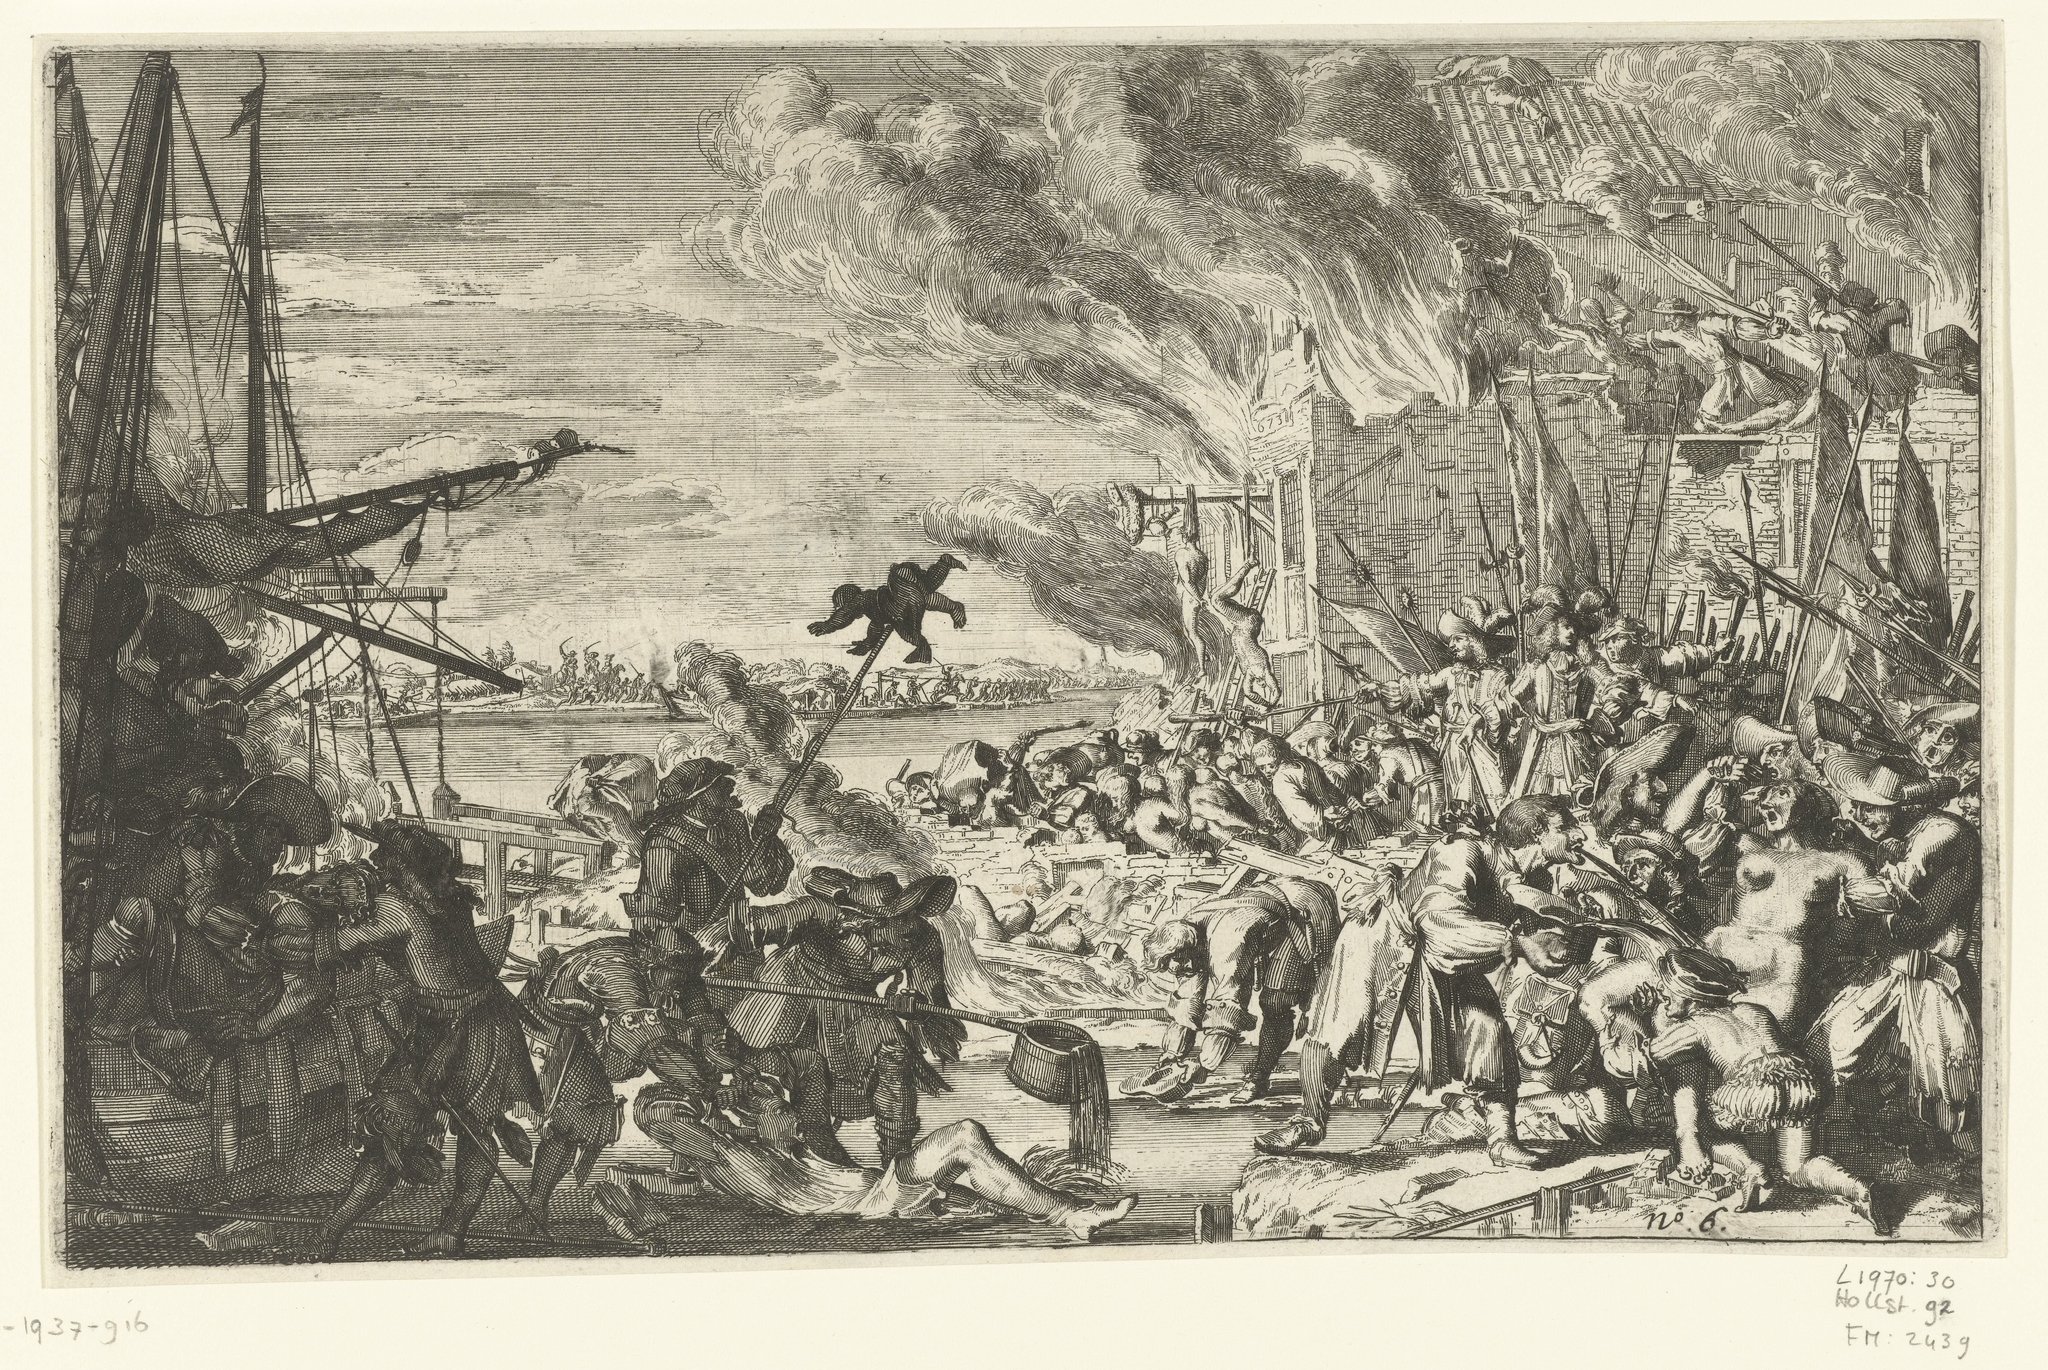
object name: print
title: Wreedheden in een dorp aan het water, 1672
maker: Anonymous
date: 1673-1675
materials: paper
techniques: engraving, etching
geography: netherlands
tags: massacre ~ war, bodegraven, rampjaar (disaster year)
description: Prent ook gebruikt in: Bosch, Lambert van den. Toneel des oorlogs, opgerecht in de Vereenigde Nederlanden; door de wapenen van de koningen van Vrankrijk en Engeland, Keulsche en Munstersche (…). 4 delen. Amsterdam: Jacob van Meurs en Johannes van Someren, 1675, dl. 3, p. 128. In tegenstelling tot de andere prenten in deze reeks is deze voorstelling niet opgenomen in: Valckenier, Peter en Andreas Muller. Das verwirrte Europa (…). 3 delen. Amsterdam: Hendrik en Dirk Boom, Joannes van Someren en Jacob van Meurs, 1677-1683, dl. 1 (1677). Deze prent is gekopieerd naar een prent van Romeyn de Hooghe (RP-P-OB-77.198). Die prent is gebruikt in: Wicquefort, Abraham van. Avis fidelle aux veritables hollandois. Touchant ce qui s’est passé dans les villages de Bodegrave & Swammerdam, & les cruautés inoüies, que les françois y ont exercées (…). S.l. [Den Haag]: s.n.[Daniel en Johannes Steucker], 1673.